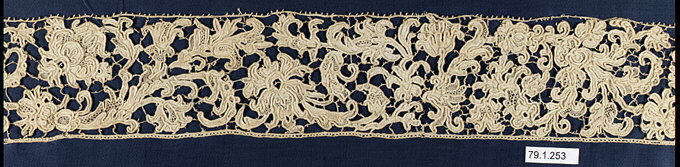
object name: strip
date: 1601-1700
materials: lace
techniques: gros point, lace